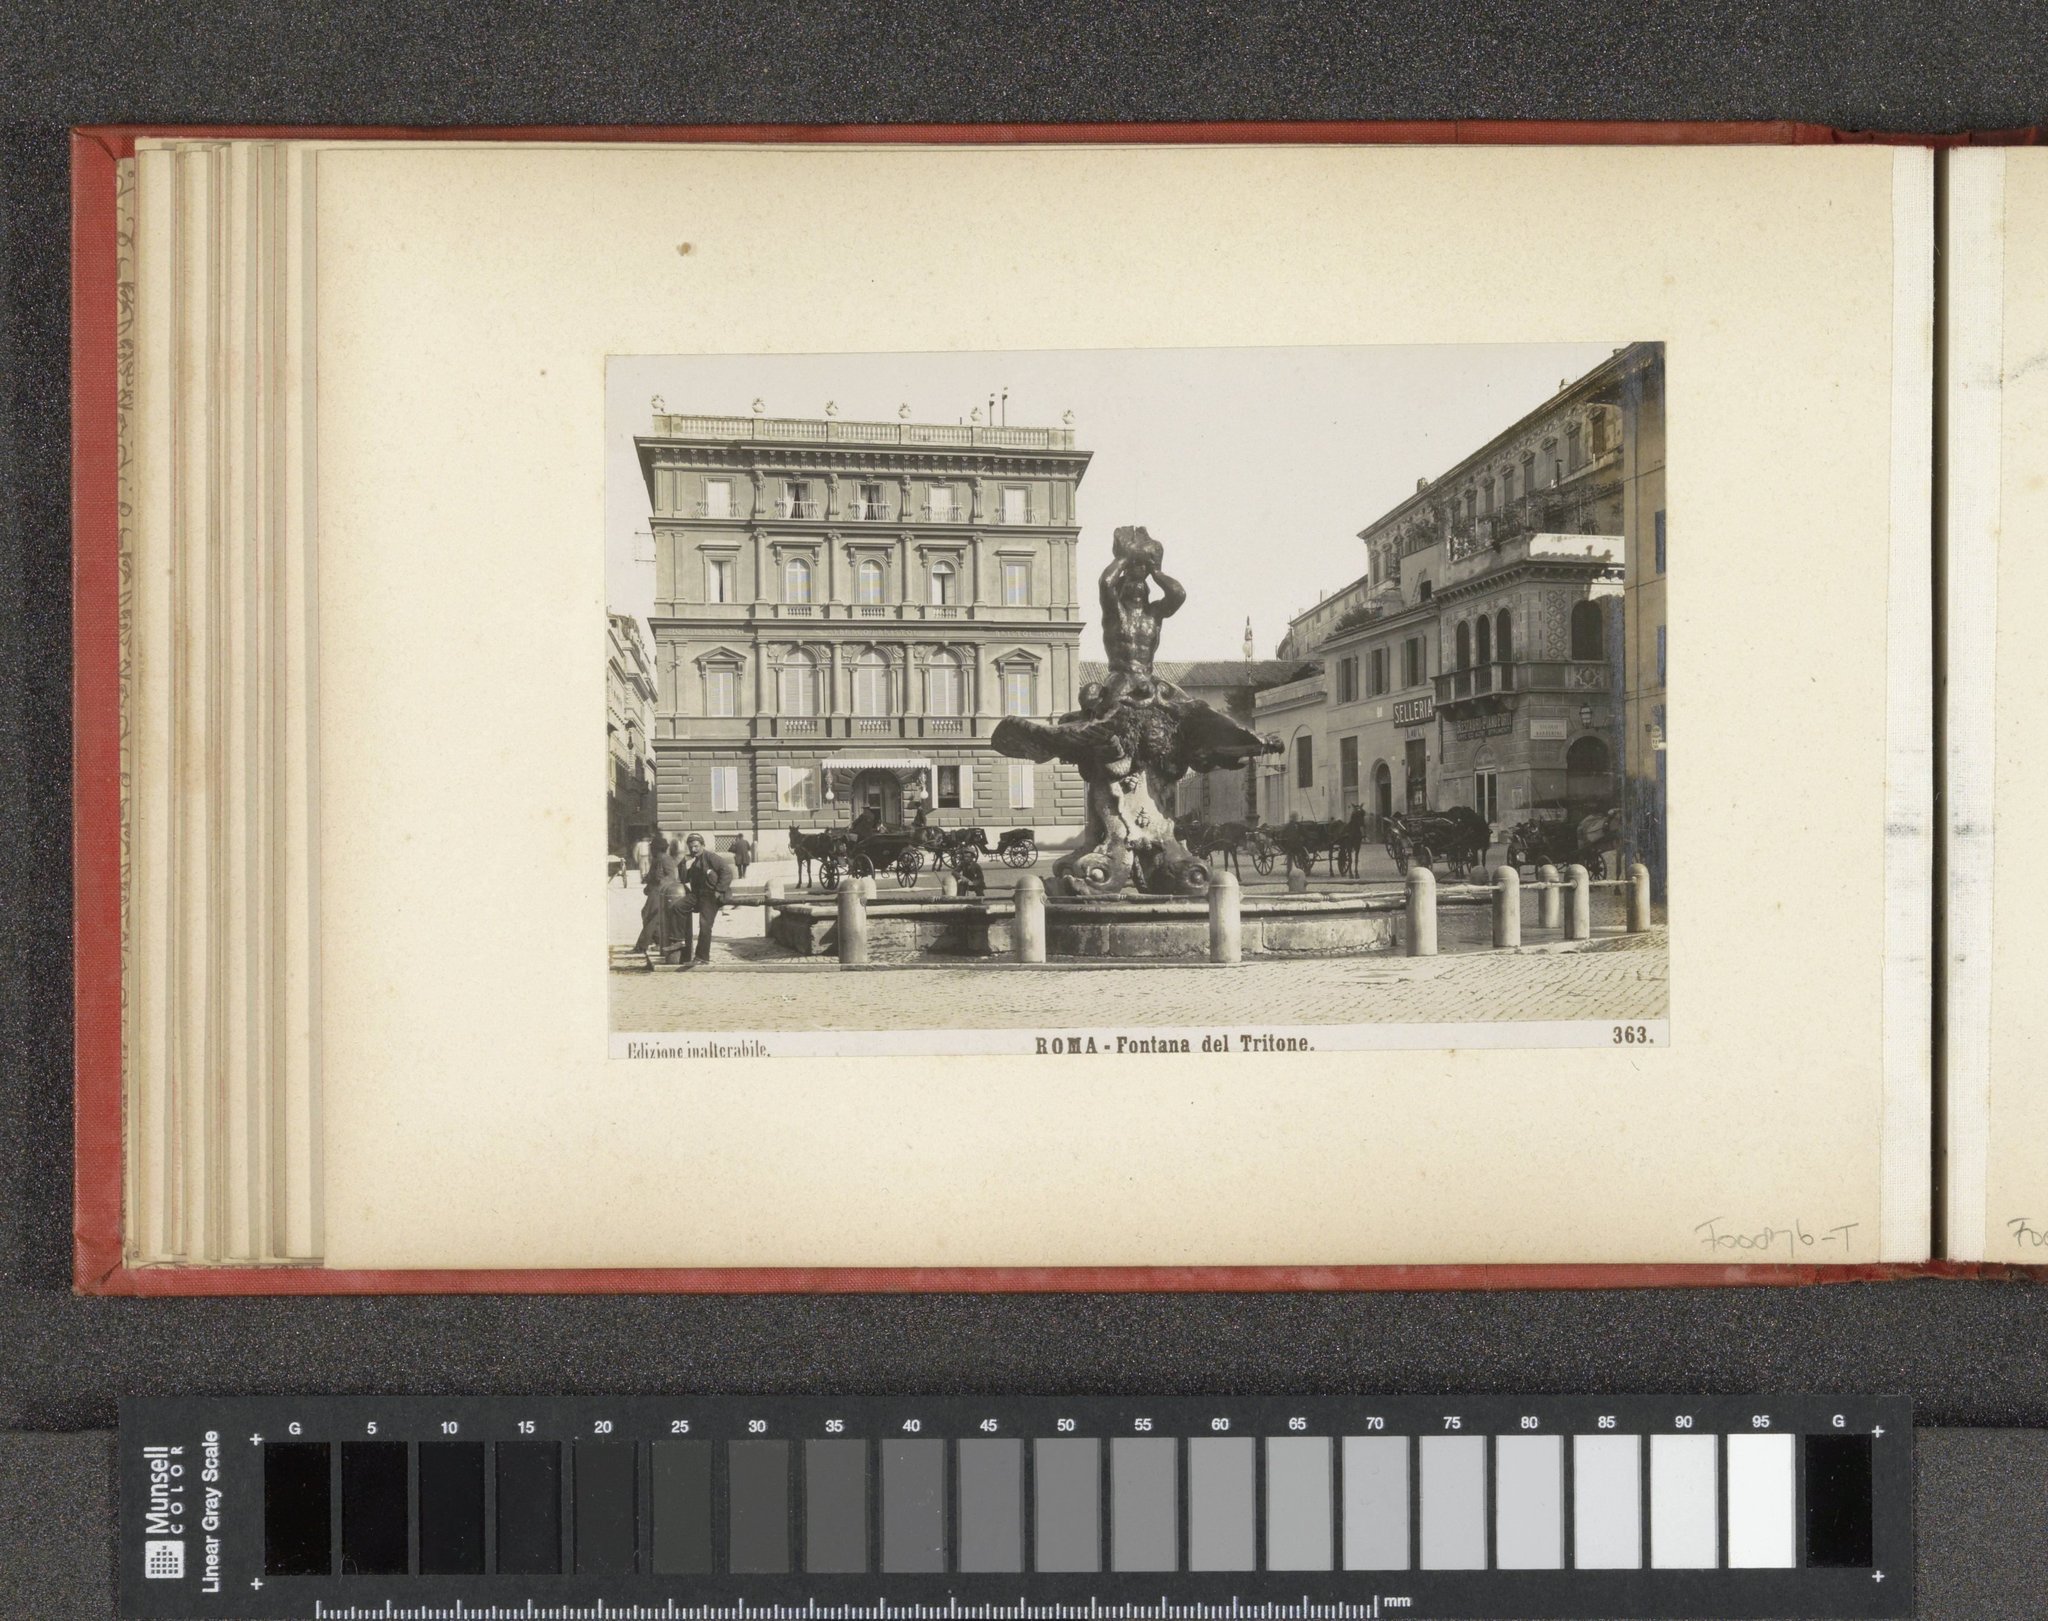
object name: photograph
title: Fontana del Tritone op de Piazza Barberini in Rome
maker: Anonymous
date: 1860-1890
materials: cardboard, photographic support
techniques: gelatin silver print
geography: rome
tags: square, place, circus, etc. (+ city(-scape) with figures, staffage), ornamental fountain (+ city(-scape) with figures, staffage), prospect of city, town panorama, silhouette of city, rome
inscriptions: number: ‘363’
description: Onderdeel van Fotoalbum met opnames van kerken, beelden en antieke gebouwen in Rome.